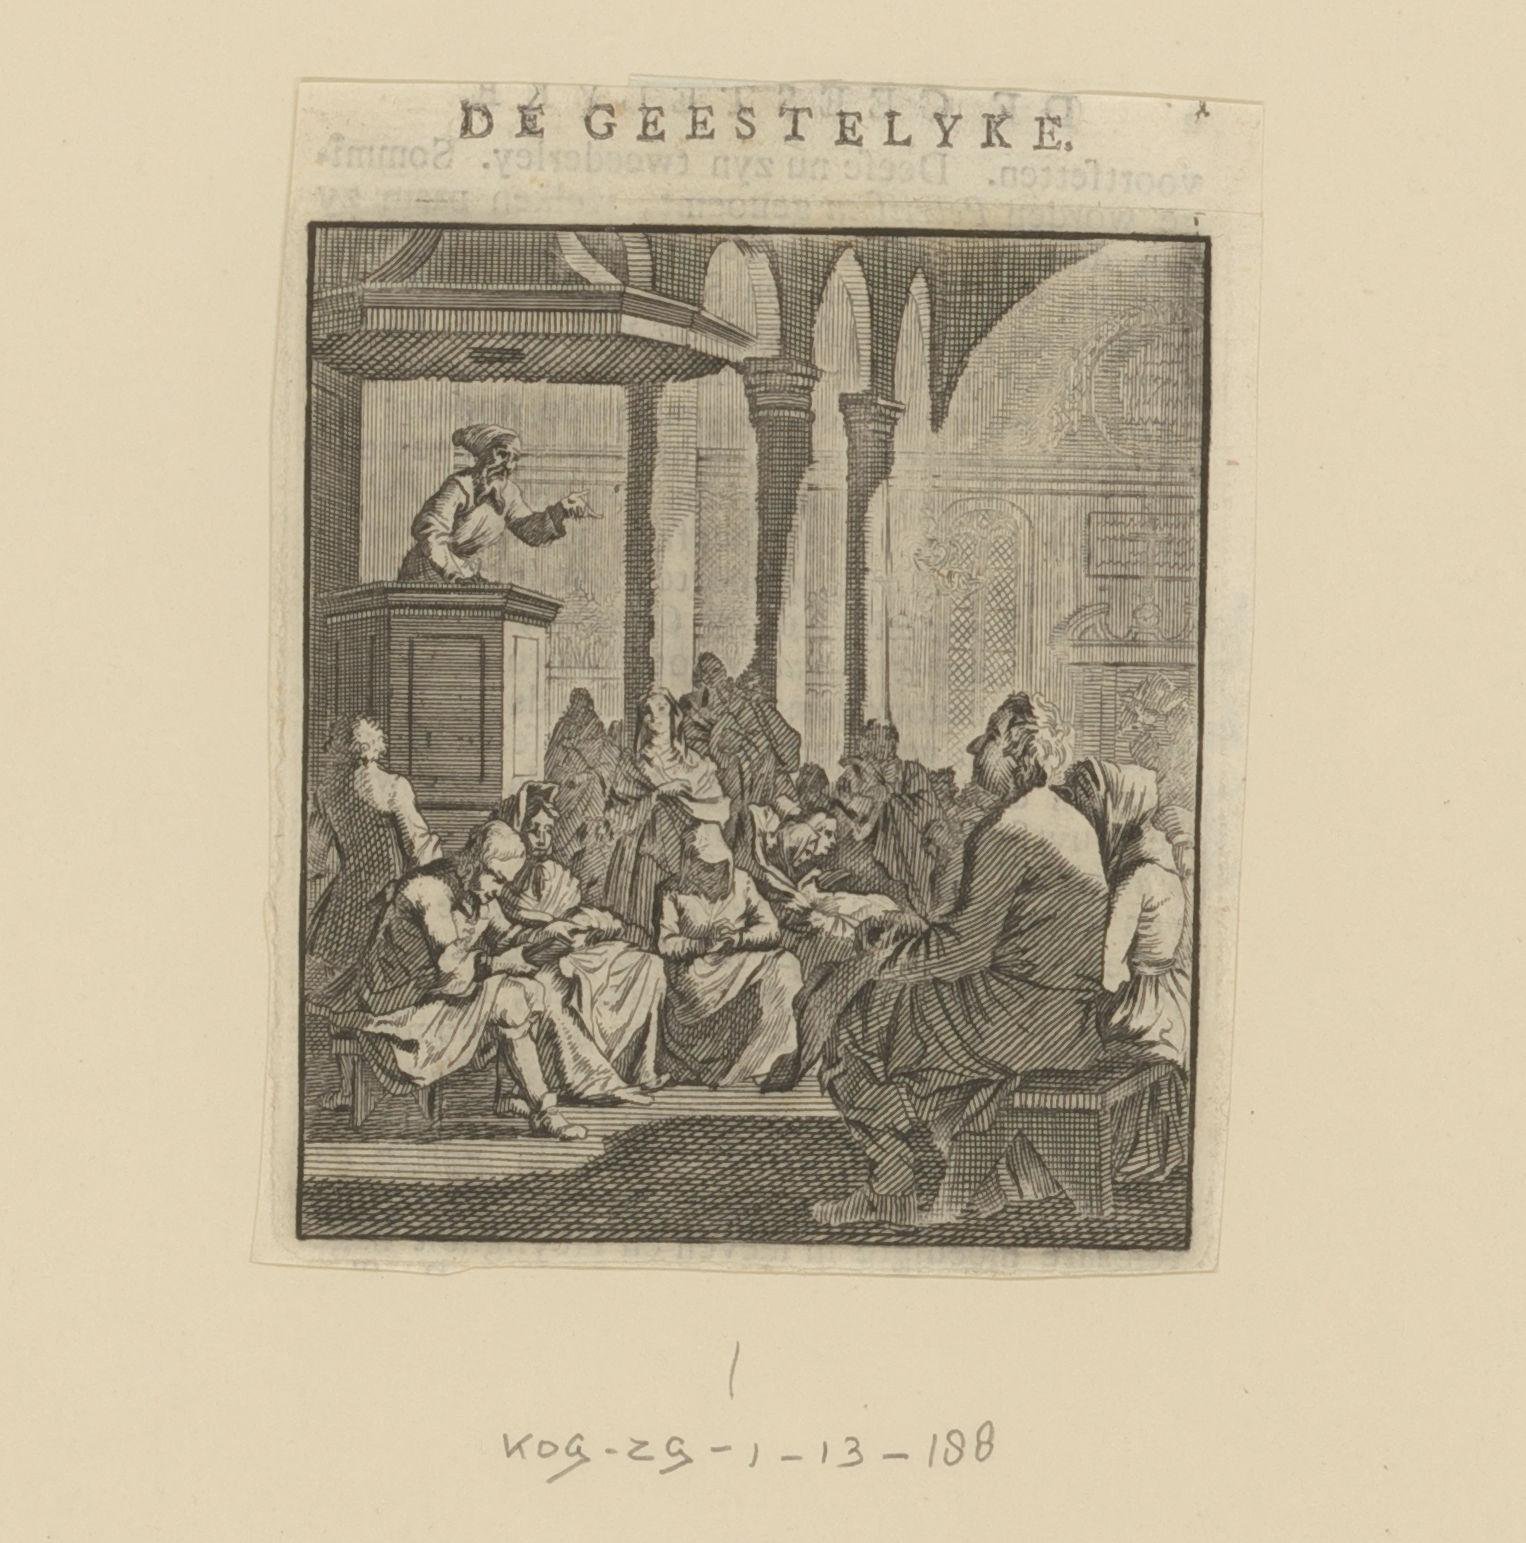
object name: print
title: De Geestelyke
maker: Anonymous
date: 1719-1759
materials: paper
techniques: etching, letterpress printing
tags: interior of church, pulpit, ambo, chancel, preaching (in general)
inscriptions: collector's mark: Lugt 1641, stamp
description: Prent met andere letterzetting gebruikt in: St. Clara, Abraham van. Iets voor allen. [Vertaald door] J. le Long. Amsterdam: Janssoons van Waesberge, 1719, dl. 2. En in: St. Clara, Abraham van. Iets voor allen. [Vertaald door] J. le Long. Amsterdam: Jan Roman de Jonge, 1741, dl. 2. En in: St. Clara, Abraham van. Iets voor allen. [Vertaald door] J. le Long. Amsterdam: Jan Roman, 1759, dl. 2. Huidige prent uit een andere editie. Naar een prent van: Jan Luyken, De Leraar, uit: Het menselyk Bedryf.